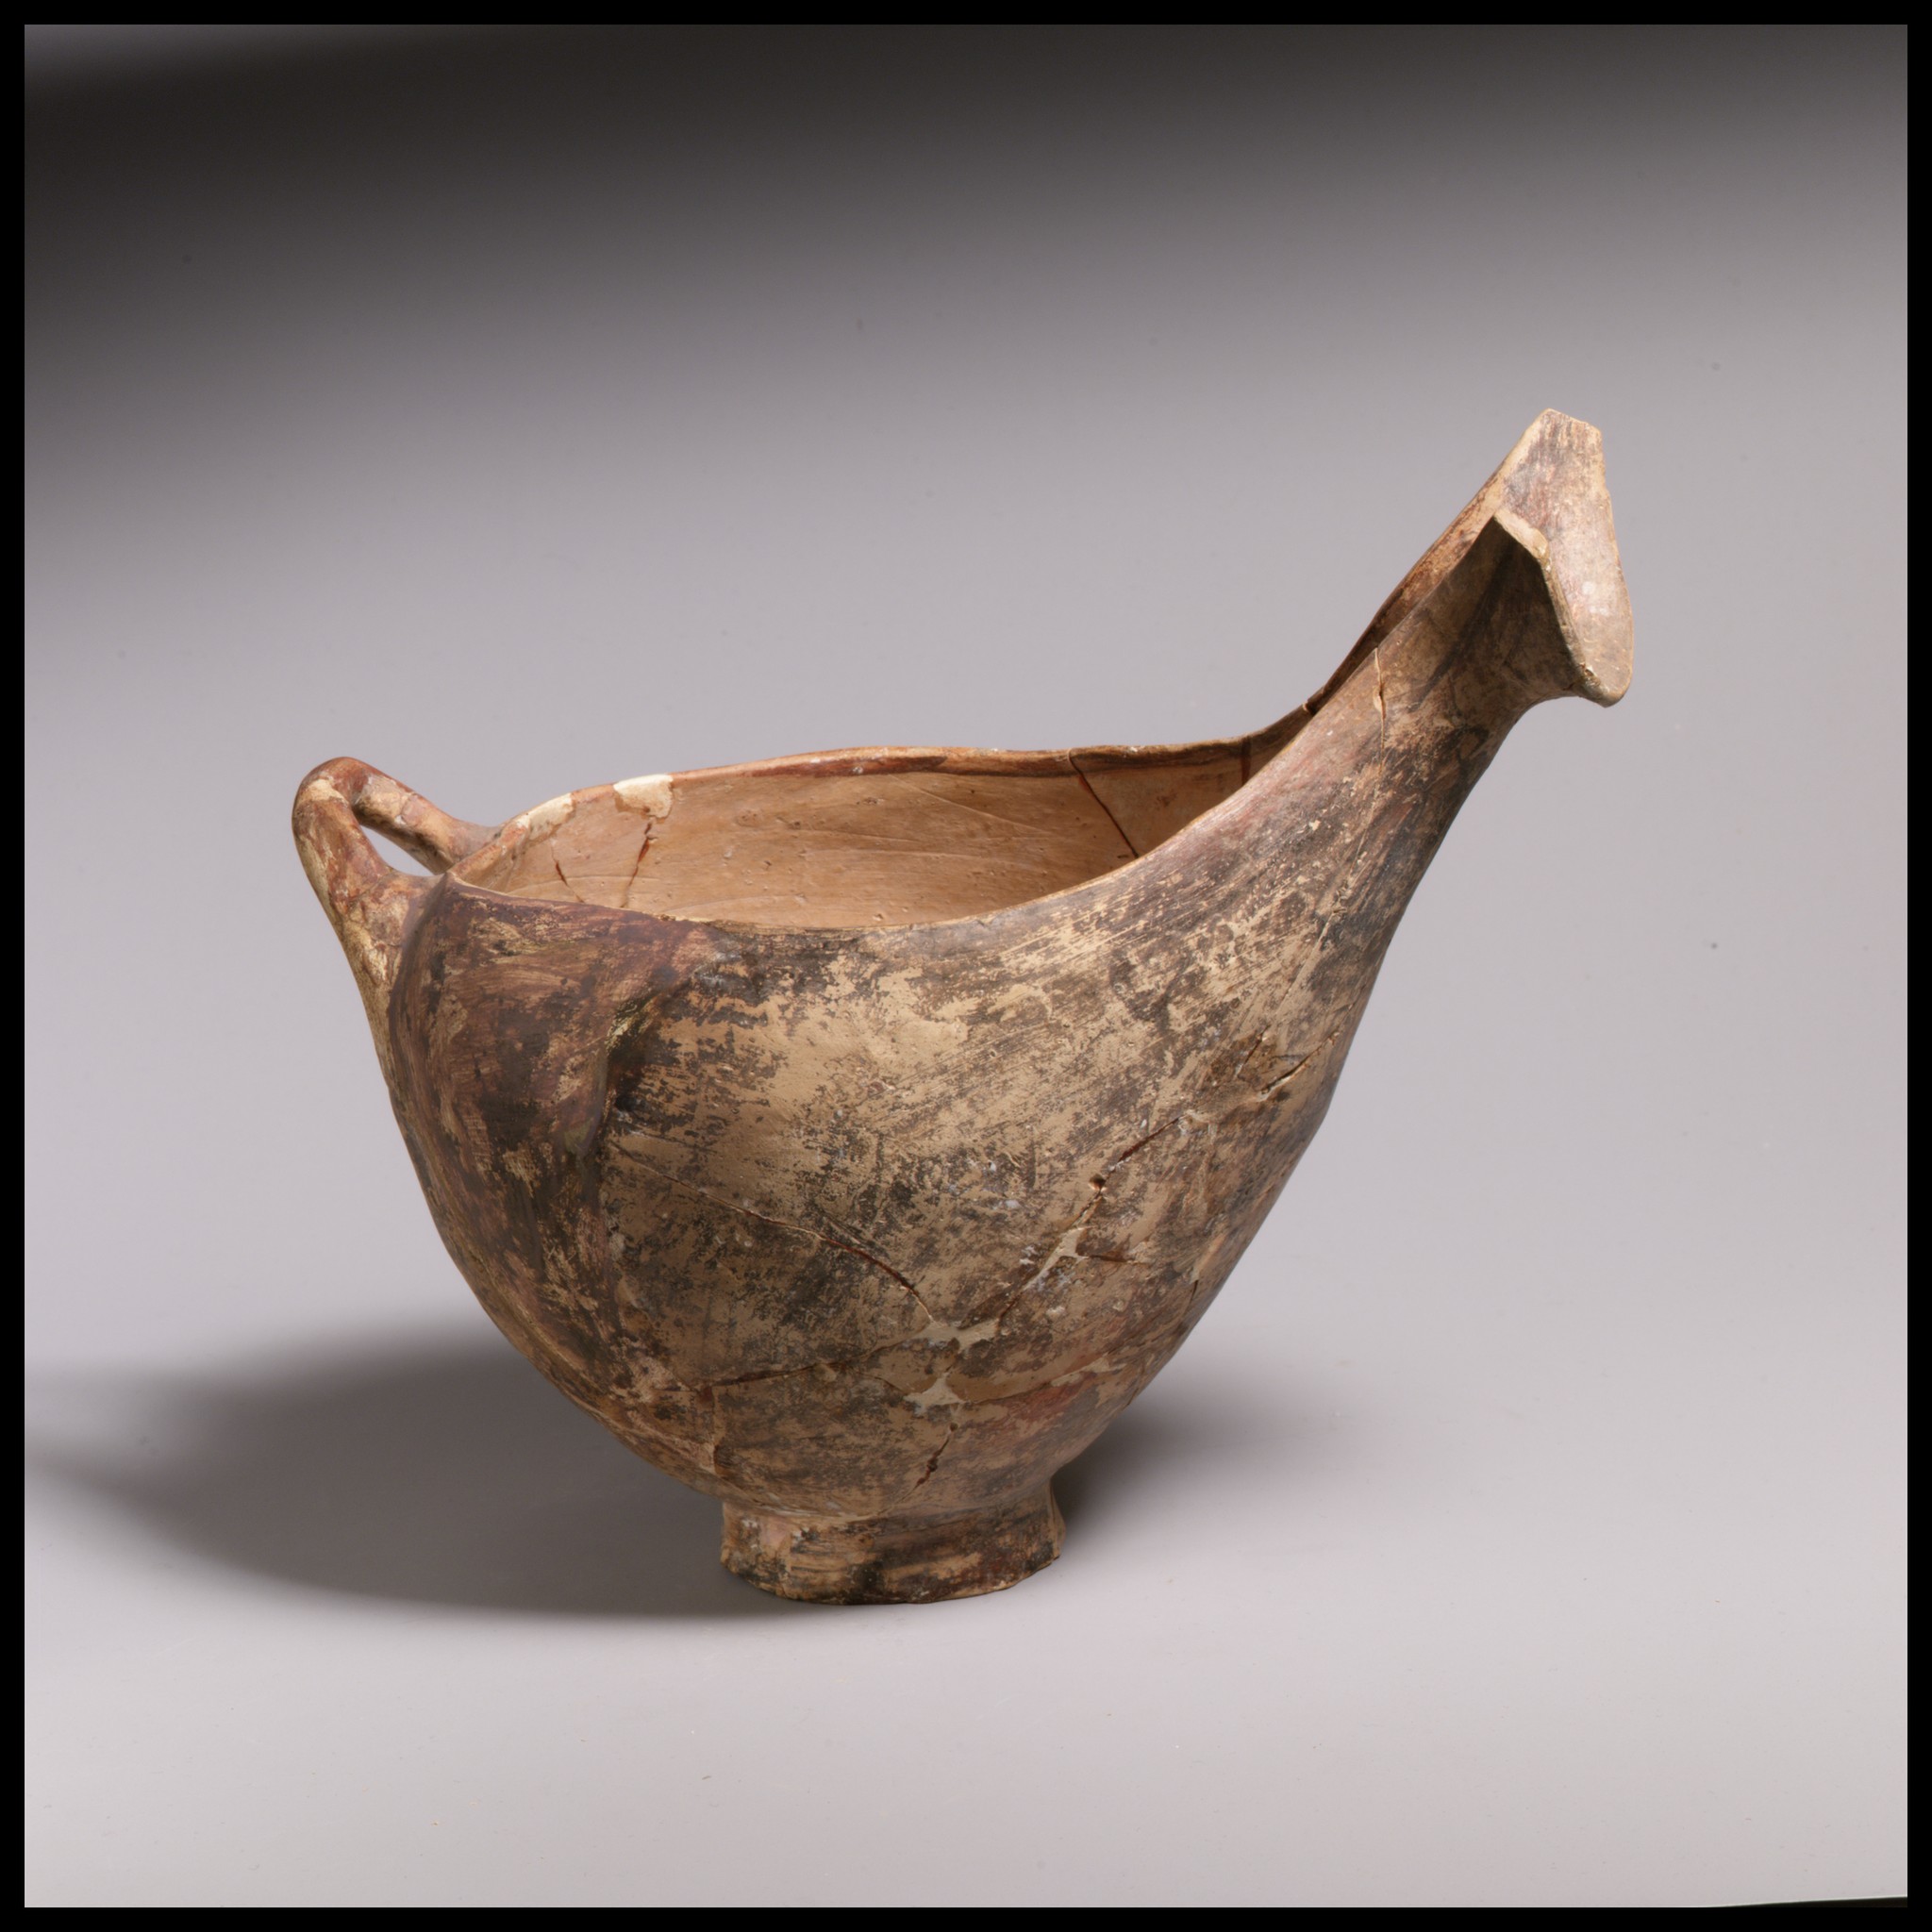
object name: jug, sauceboat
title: Terracotta sauceboat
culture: helladic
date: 2650-2150 BCE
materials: terracotta